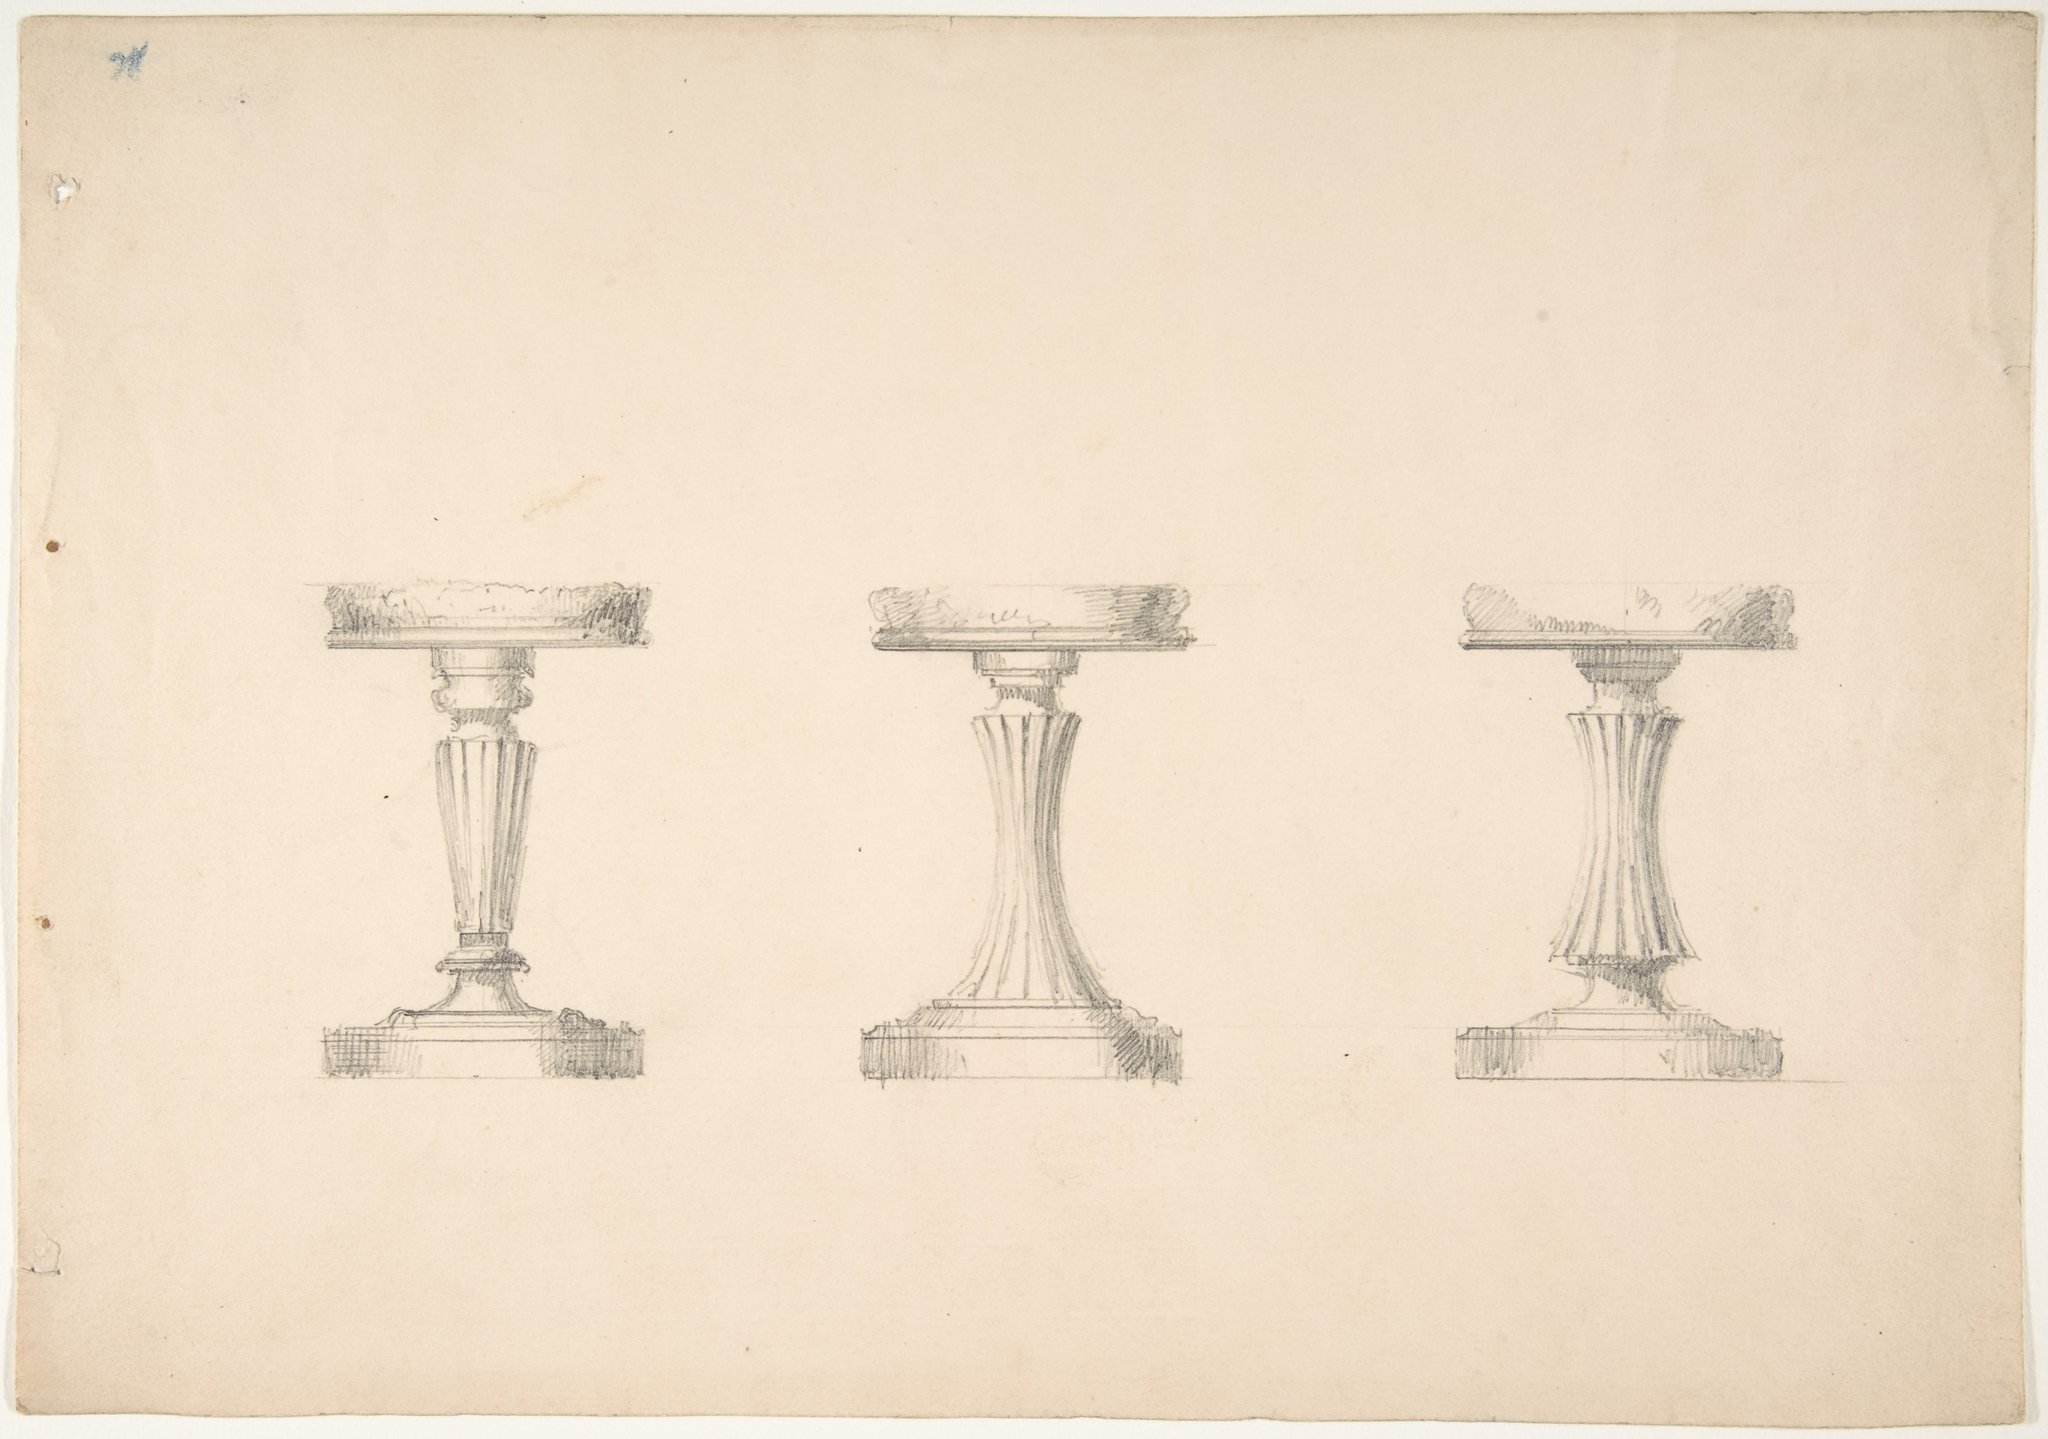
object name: drawing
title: Design for Three Stools with Columnar Supports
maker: anonymous, british, 19th century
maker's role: artist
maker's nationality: british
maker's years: 1800-1900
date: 1801-1833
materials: graphite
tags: stools